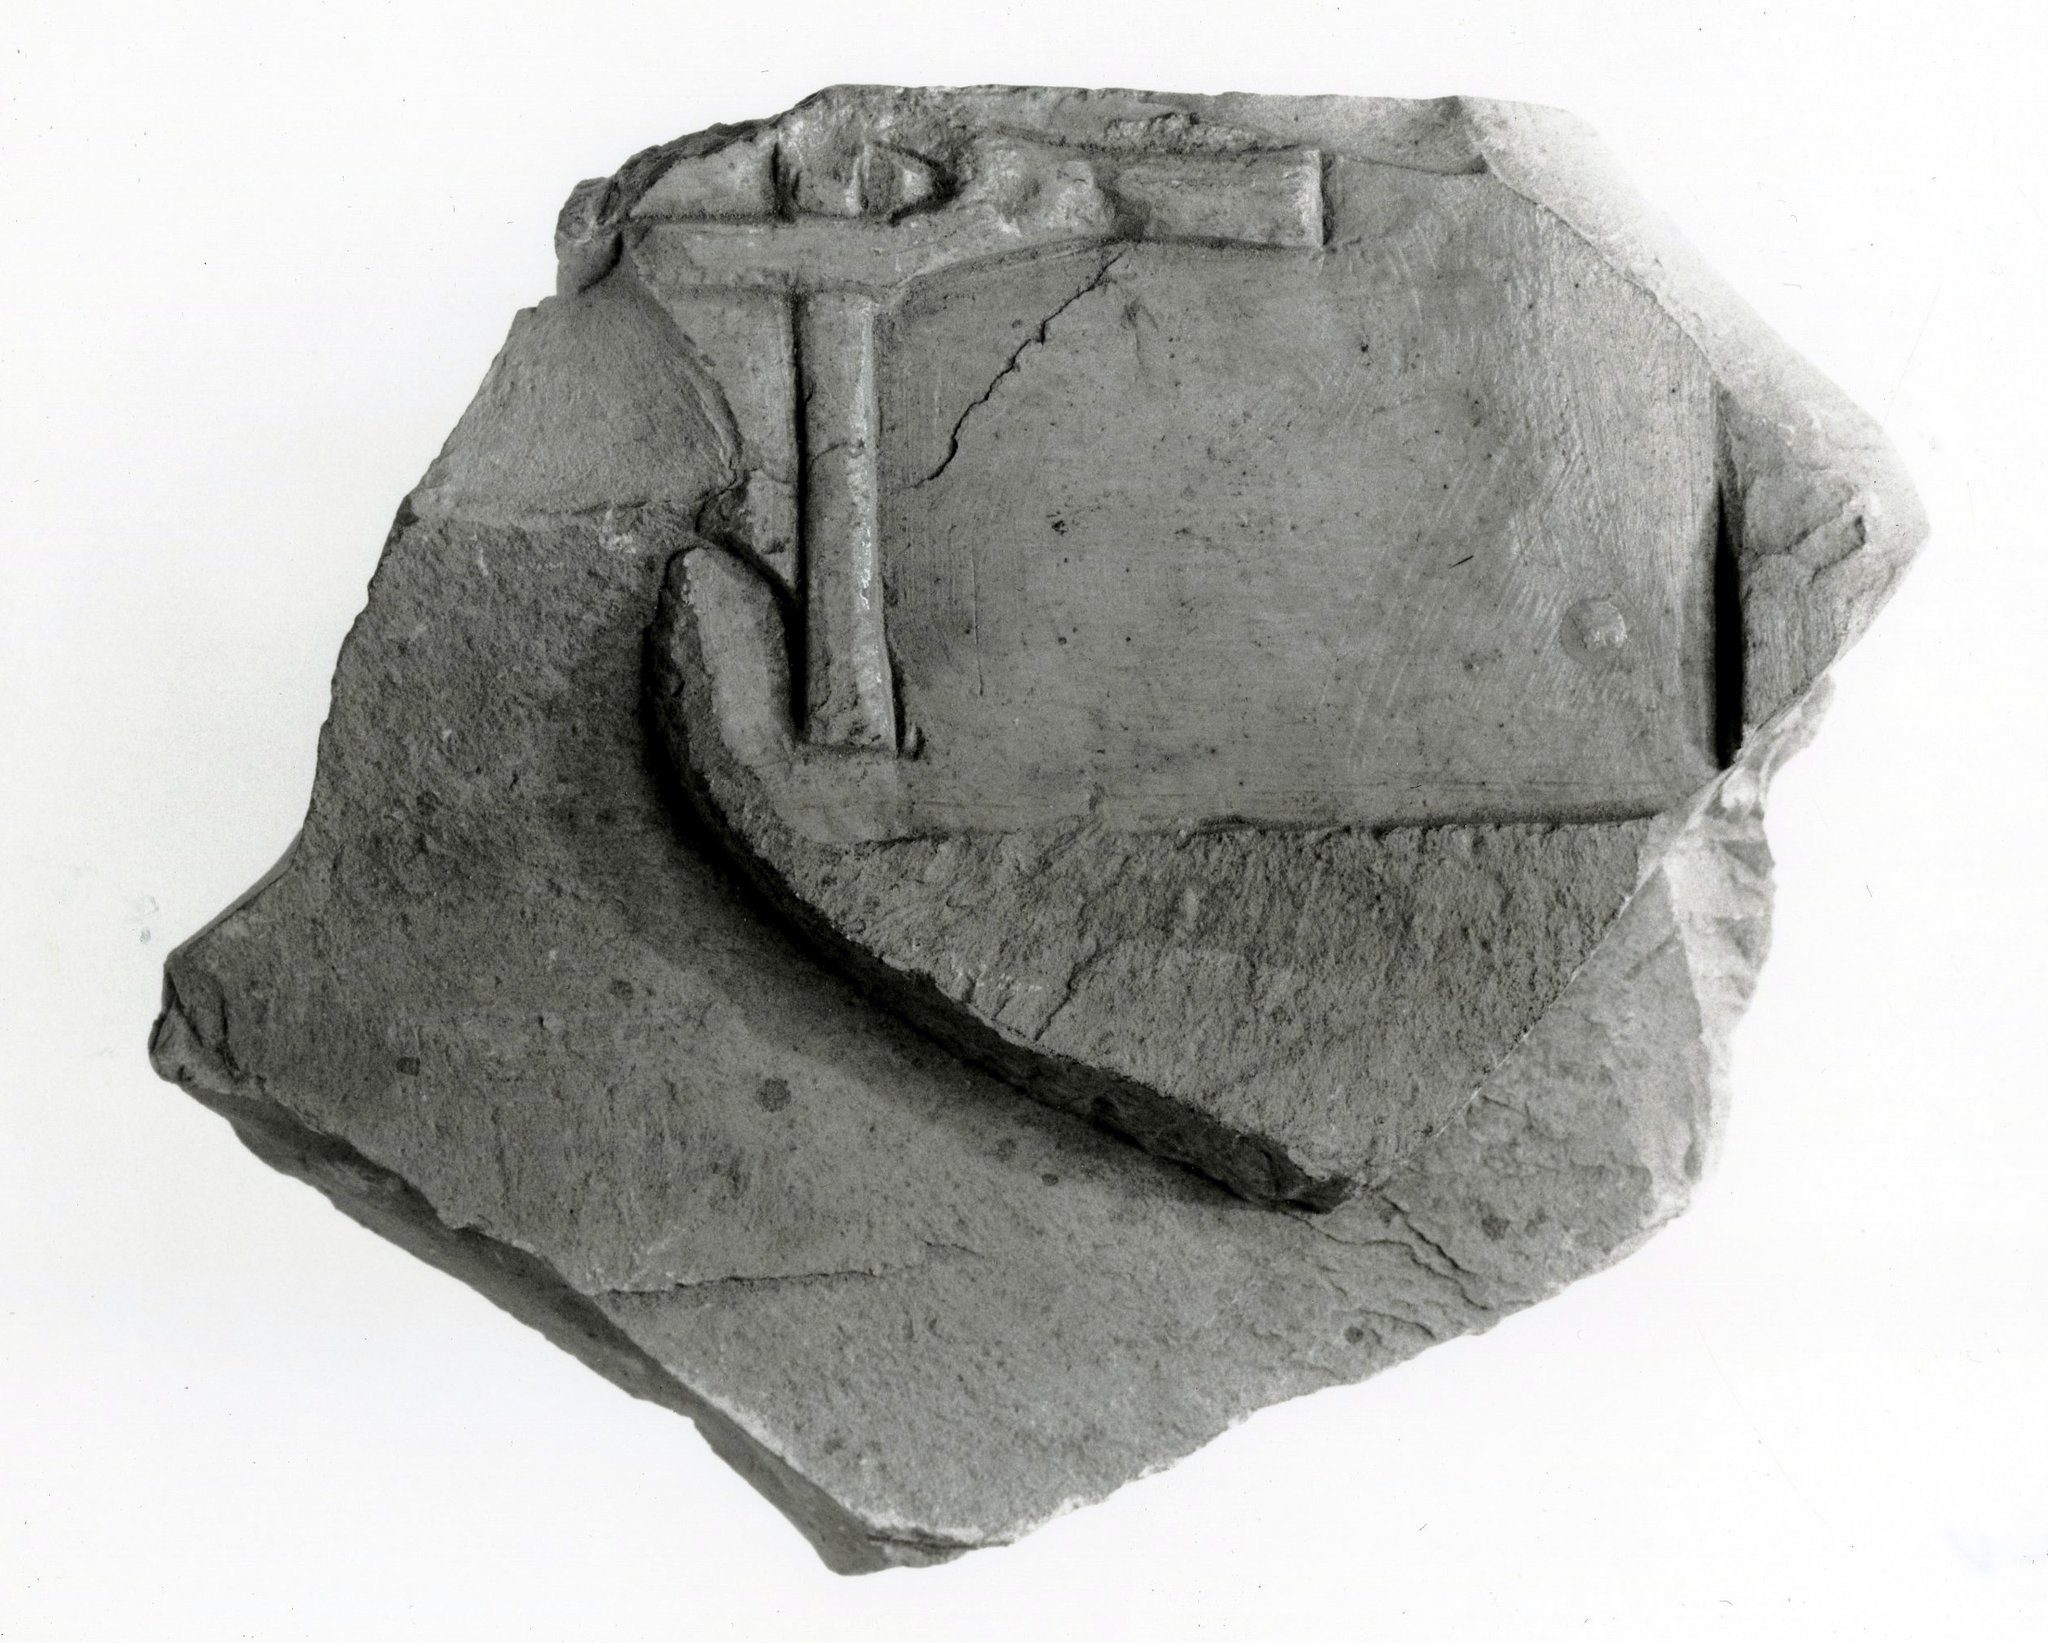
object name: relief, tomb of nespekashuty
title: Raised relief fragment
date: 664-610 BCE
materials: limestone, varnish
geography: egypt